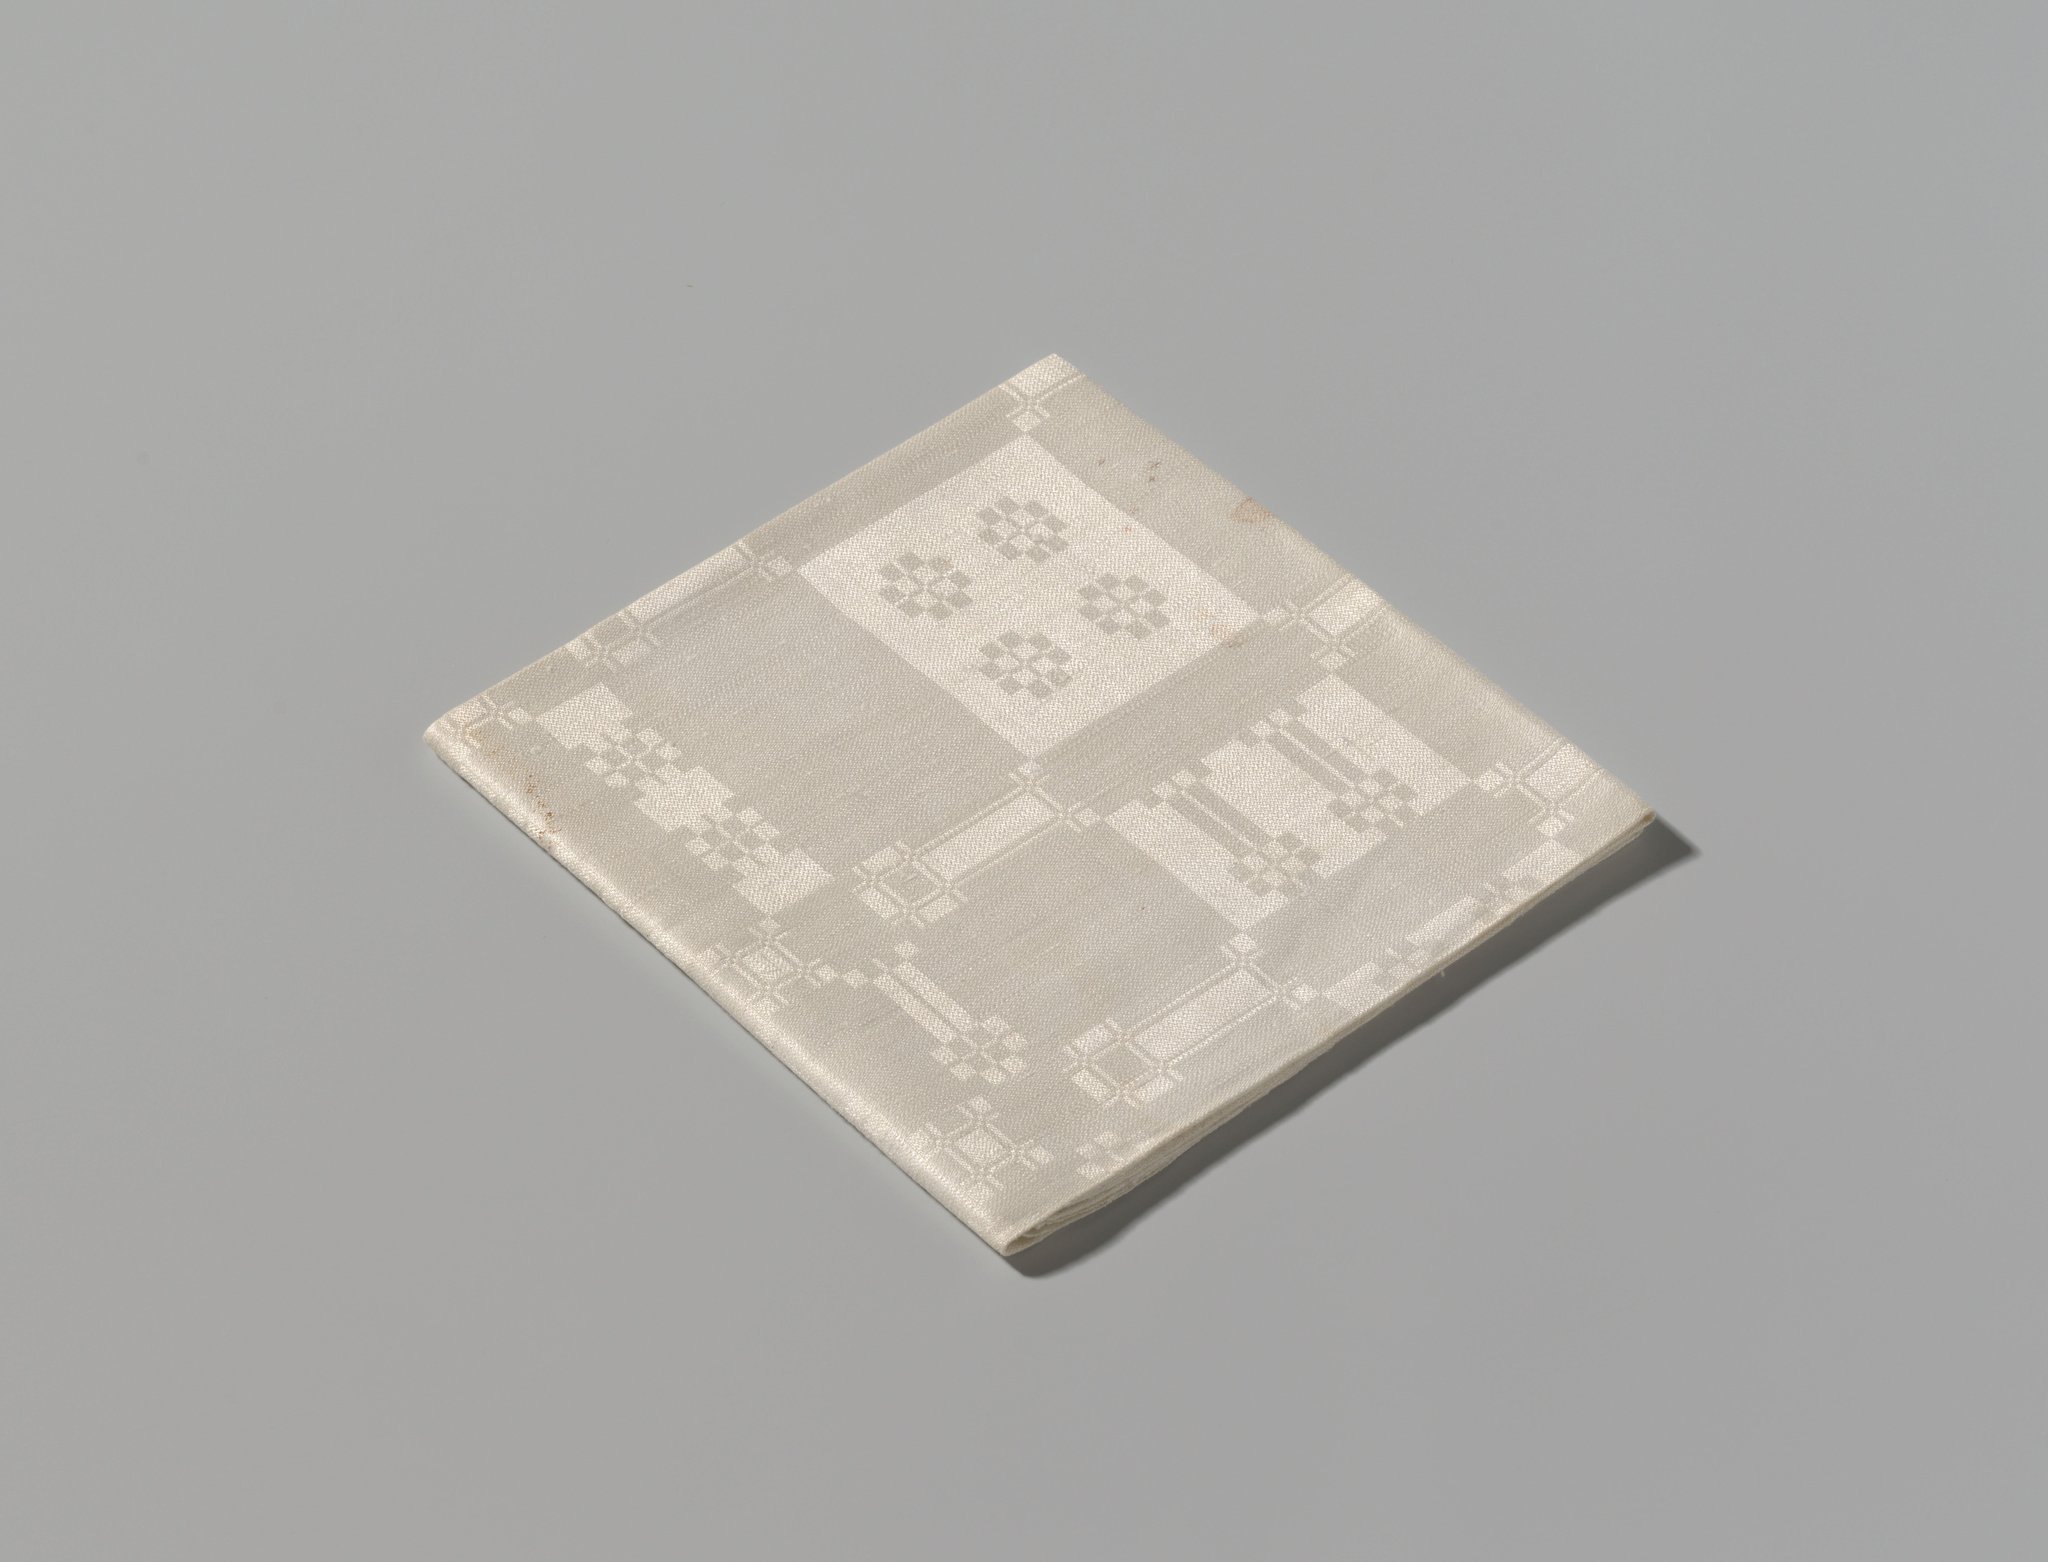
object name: napkin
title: Wit linnen pellen servet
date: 1780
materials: linen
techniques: peeled fabric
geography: northern netherlands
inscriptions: date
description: Wit linnen pellen servet, gemerkt WS 7 en 1780.